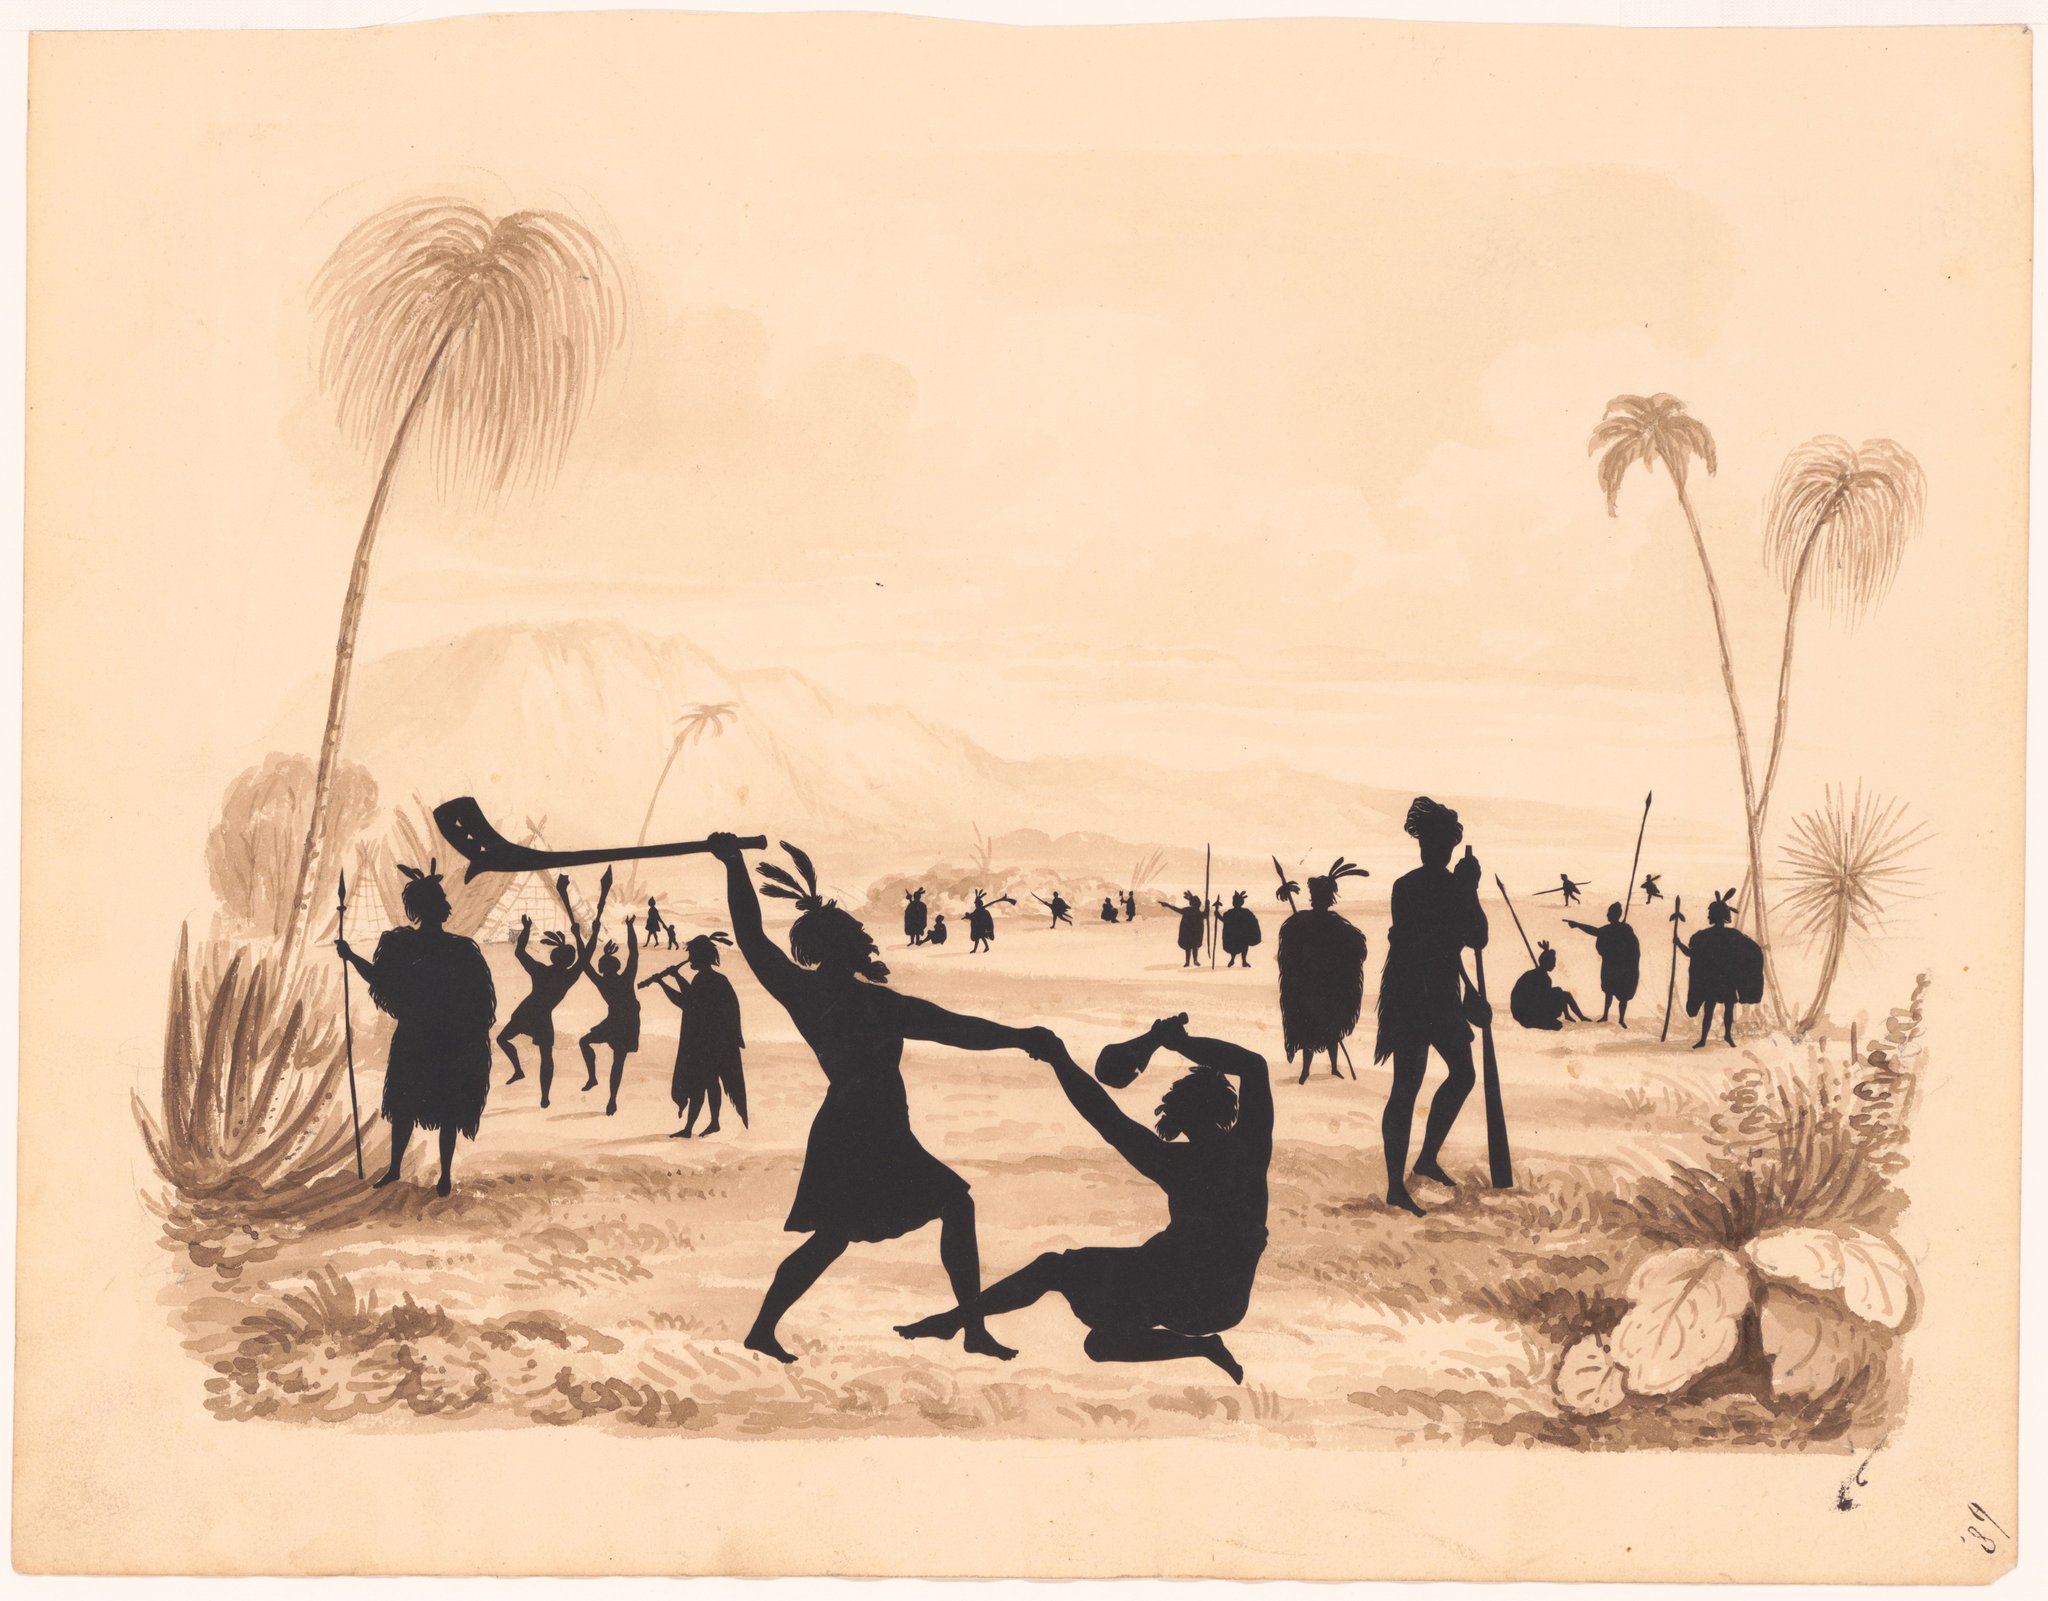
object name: cut paper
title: South Sea Islanders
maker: auguste edouart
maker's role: artist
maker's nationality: french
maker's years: 1789-1861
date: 1826-1861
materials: paper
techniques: cutting, wash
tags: human figures,weapons,trees